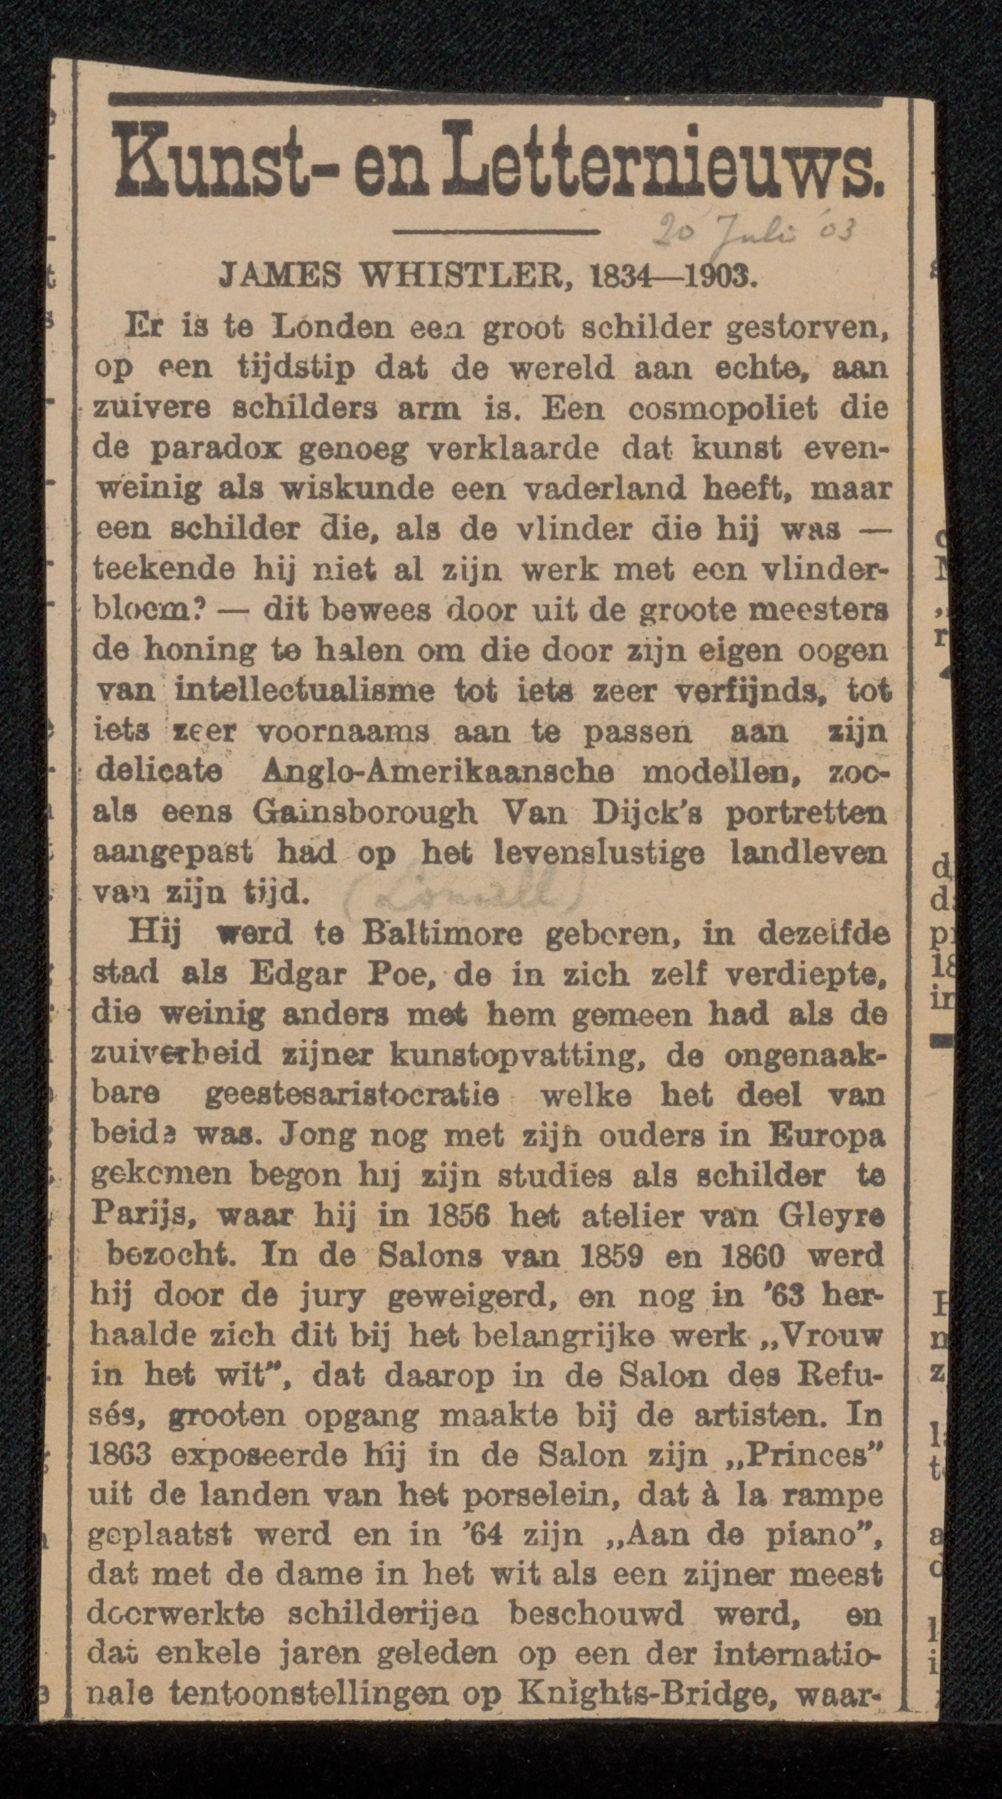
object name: newspaper clipping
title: Krantenknipsel uit archief Philip Zilcken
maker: Anonymous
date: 1903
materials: paper, ink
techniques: printing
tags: painter, print maker, james abbott mcneill whistler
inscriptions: collector's mark: ‘RPK’